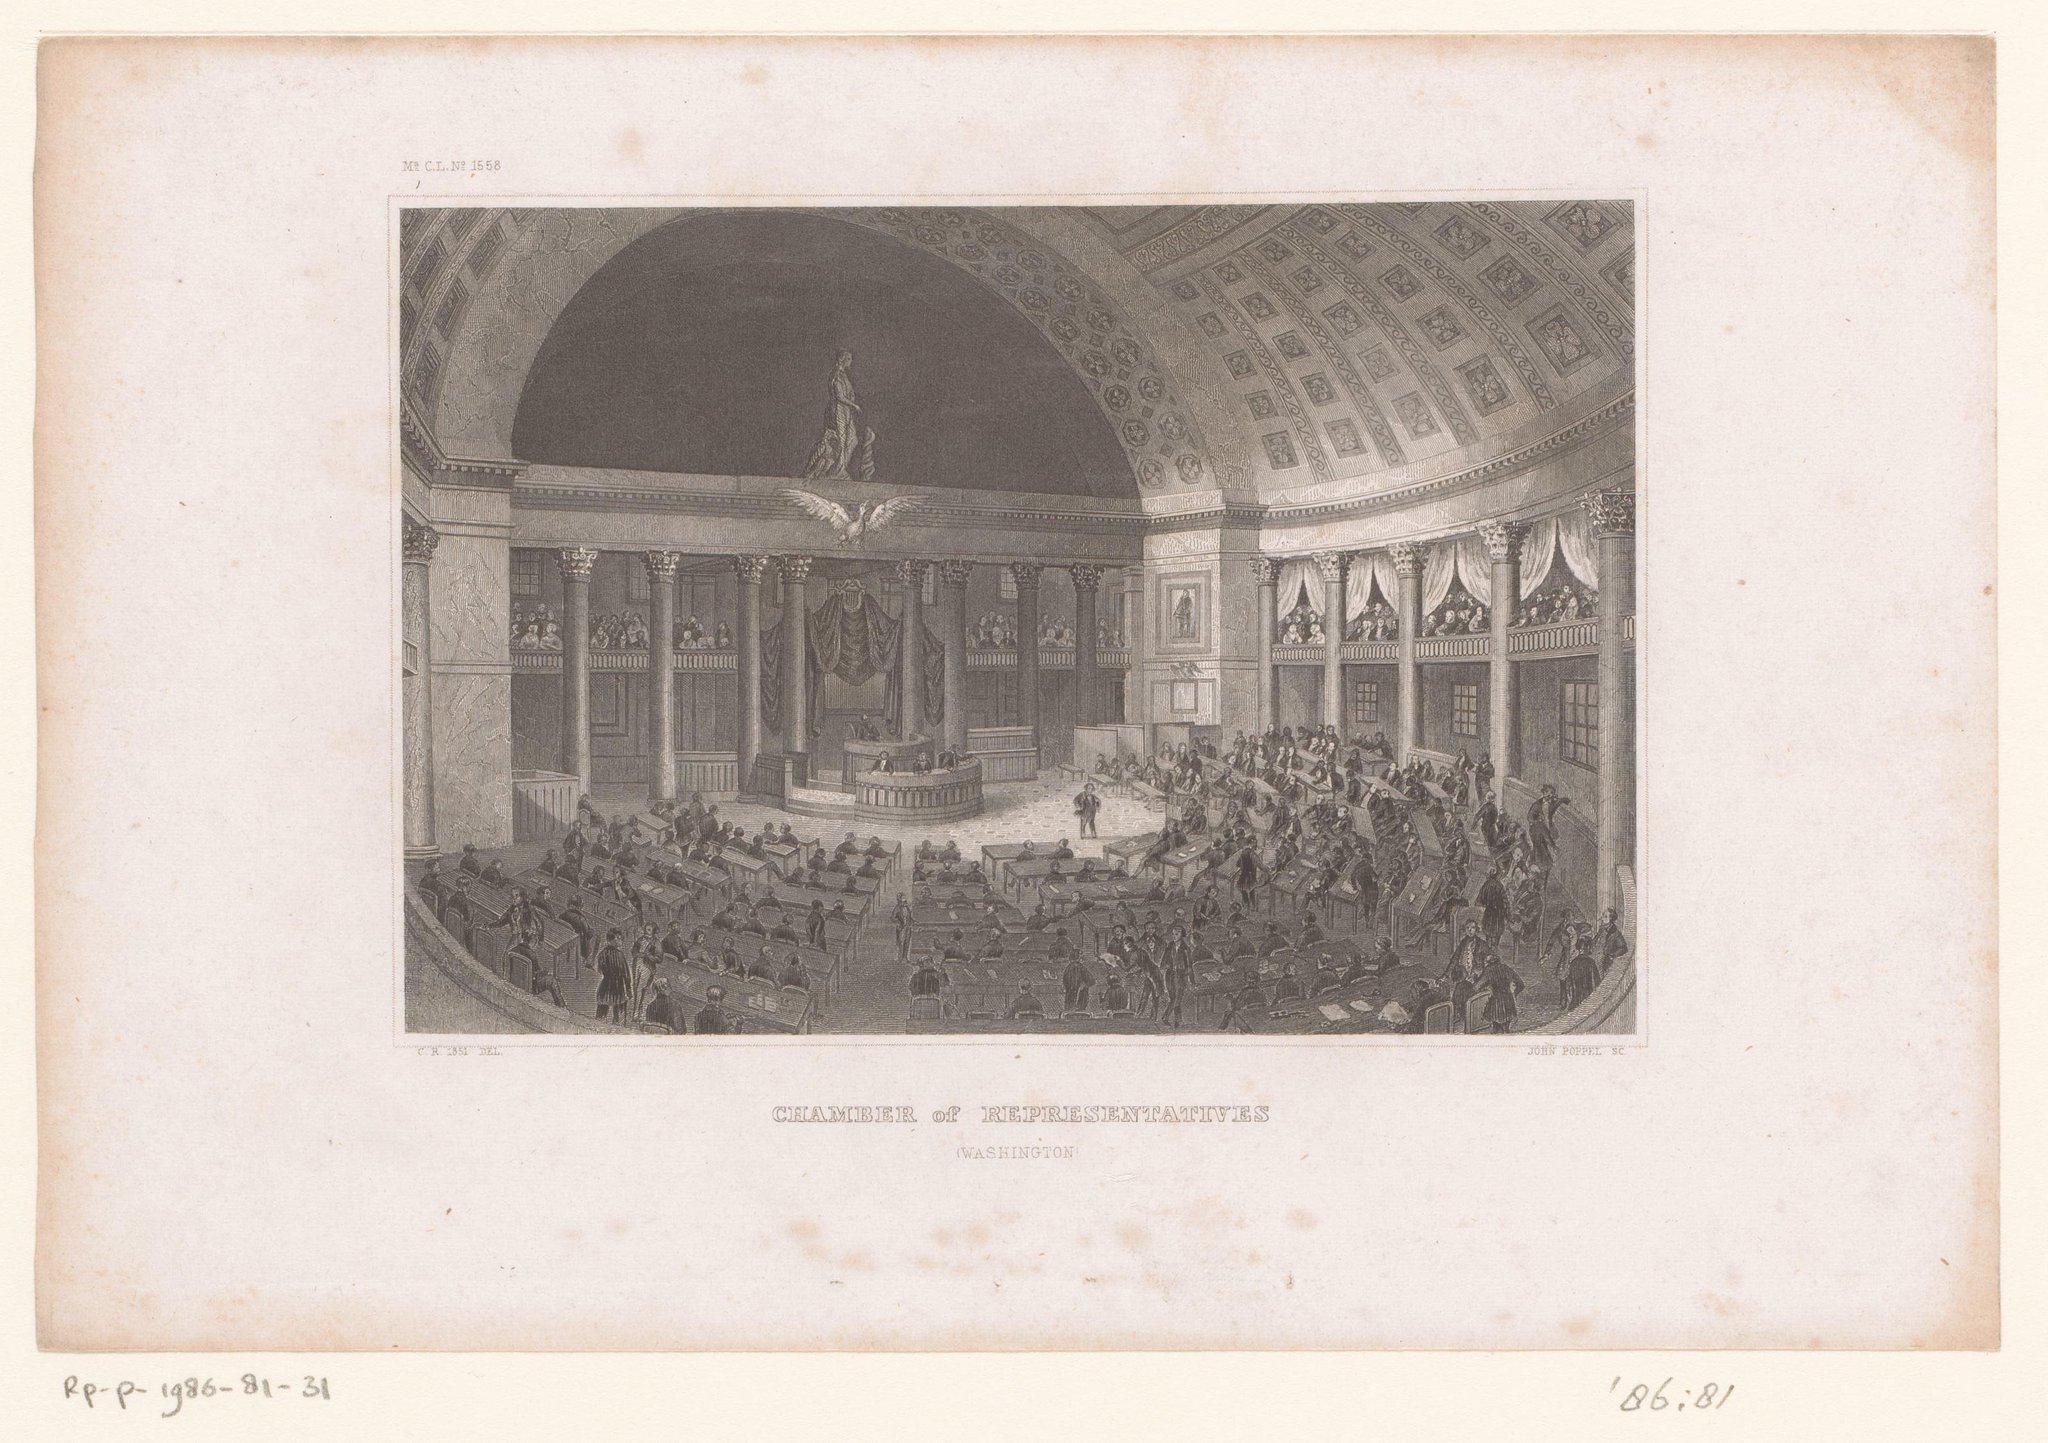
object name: print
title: Chamber of representatives, Washington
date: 1851-1863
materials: paper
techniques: engraving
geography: hildburghausen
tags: interior ~ representation of a building, lower house, parliament, chamber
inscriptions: collector's mark: Lugt 2228, monogram: ‘C.R. 1851 del.’, collector's mark: Lugt 2760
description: Prent verschenen in: Meyer, Joseph. Meyer's Universum. Hildburghausen: Bibliographisches Institut, 1835-1863.